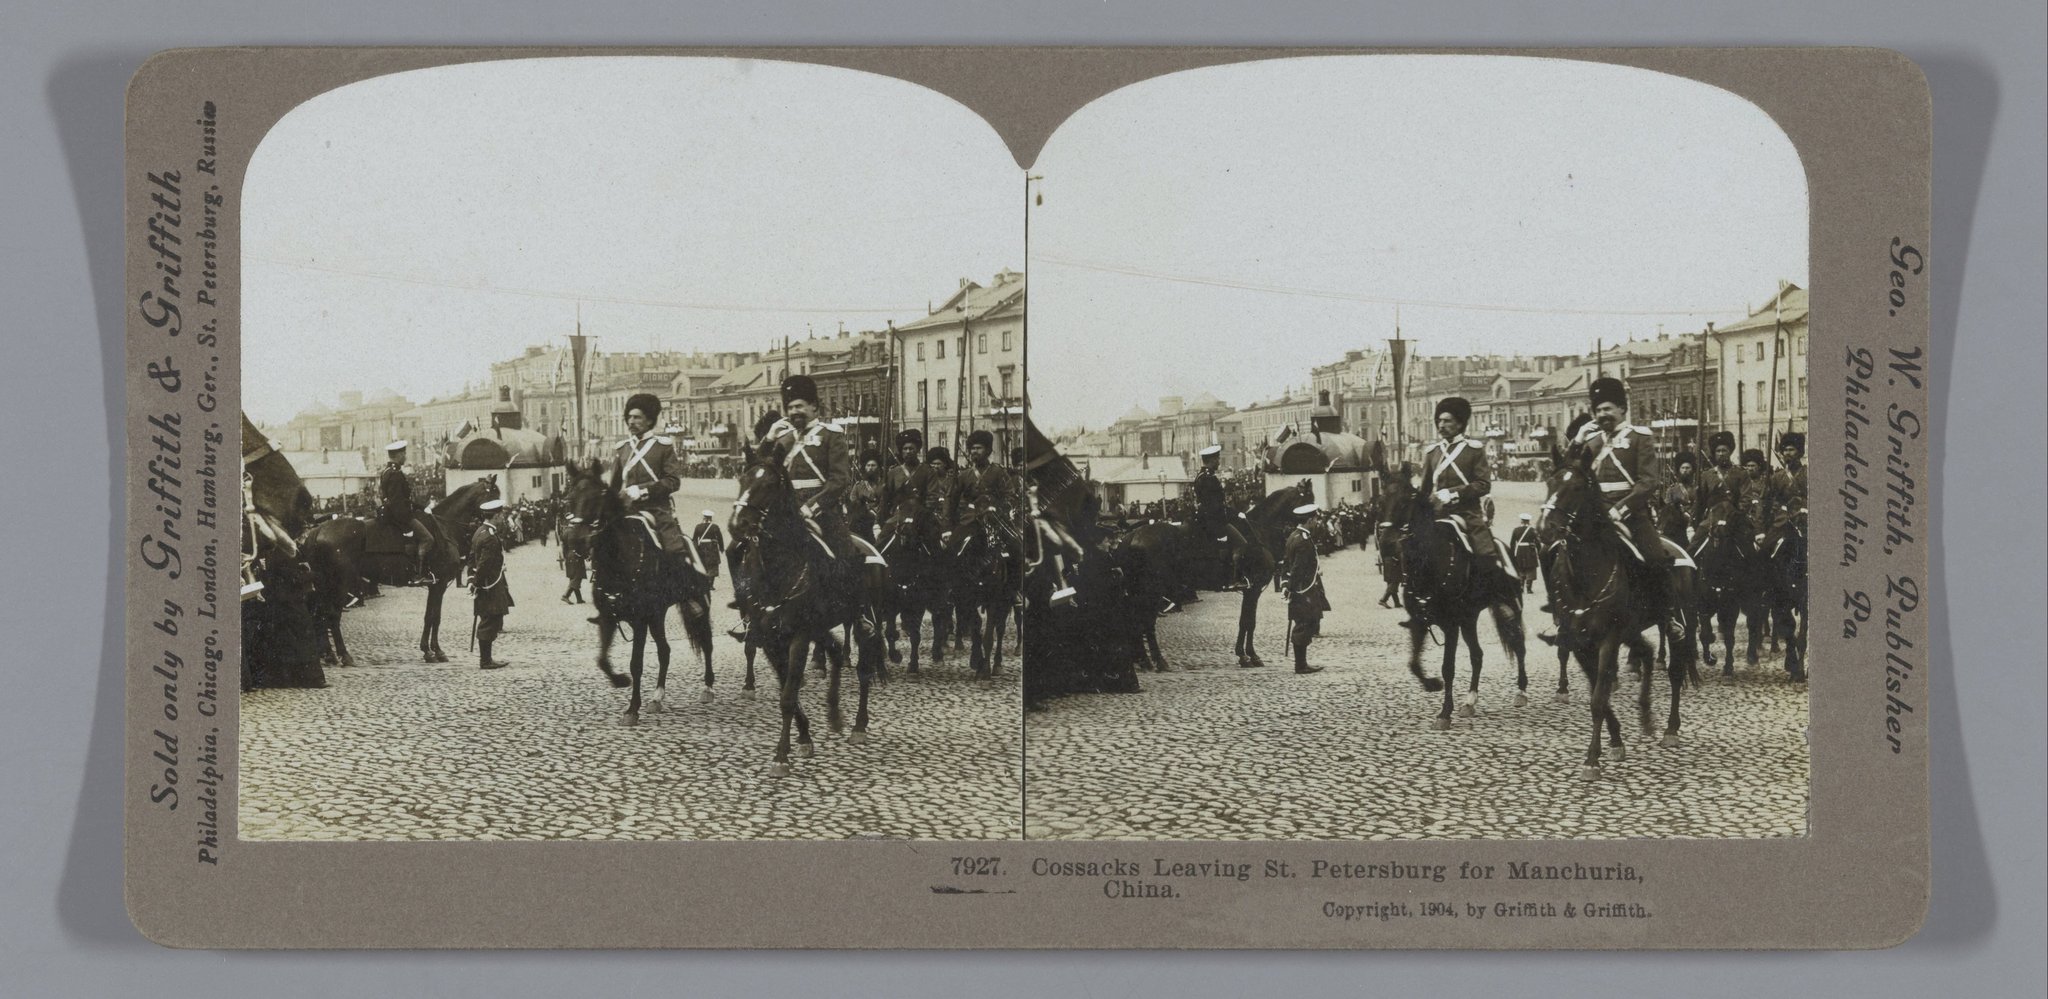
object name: stereograph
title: Cossacks Leaving St. Petersburg for Manchuria, China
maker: Anonymous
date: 1904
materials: cardboard, photographic support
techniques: gelatin silver print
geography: sint-petersburg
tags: riding a horse, ass, or mule; rider, horseman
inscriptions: number: ‘7927.’, inscription: ‘Sold only by Griffith & Griffith Philadelphia, Chicago, London, Hamburg, Ger., St. Petersburg, Russia’